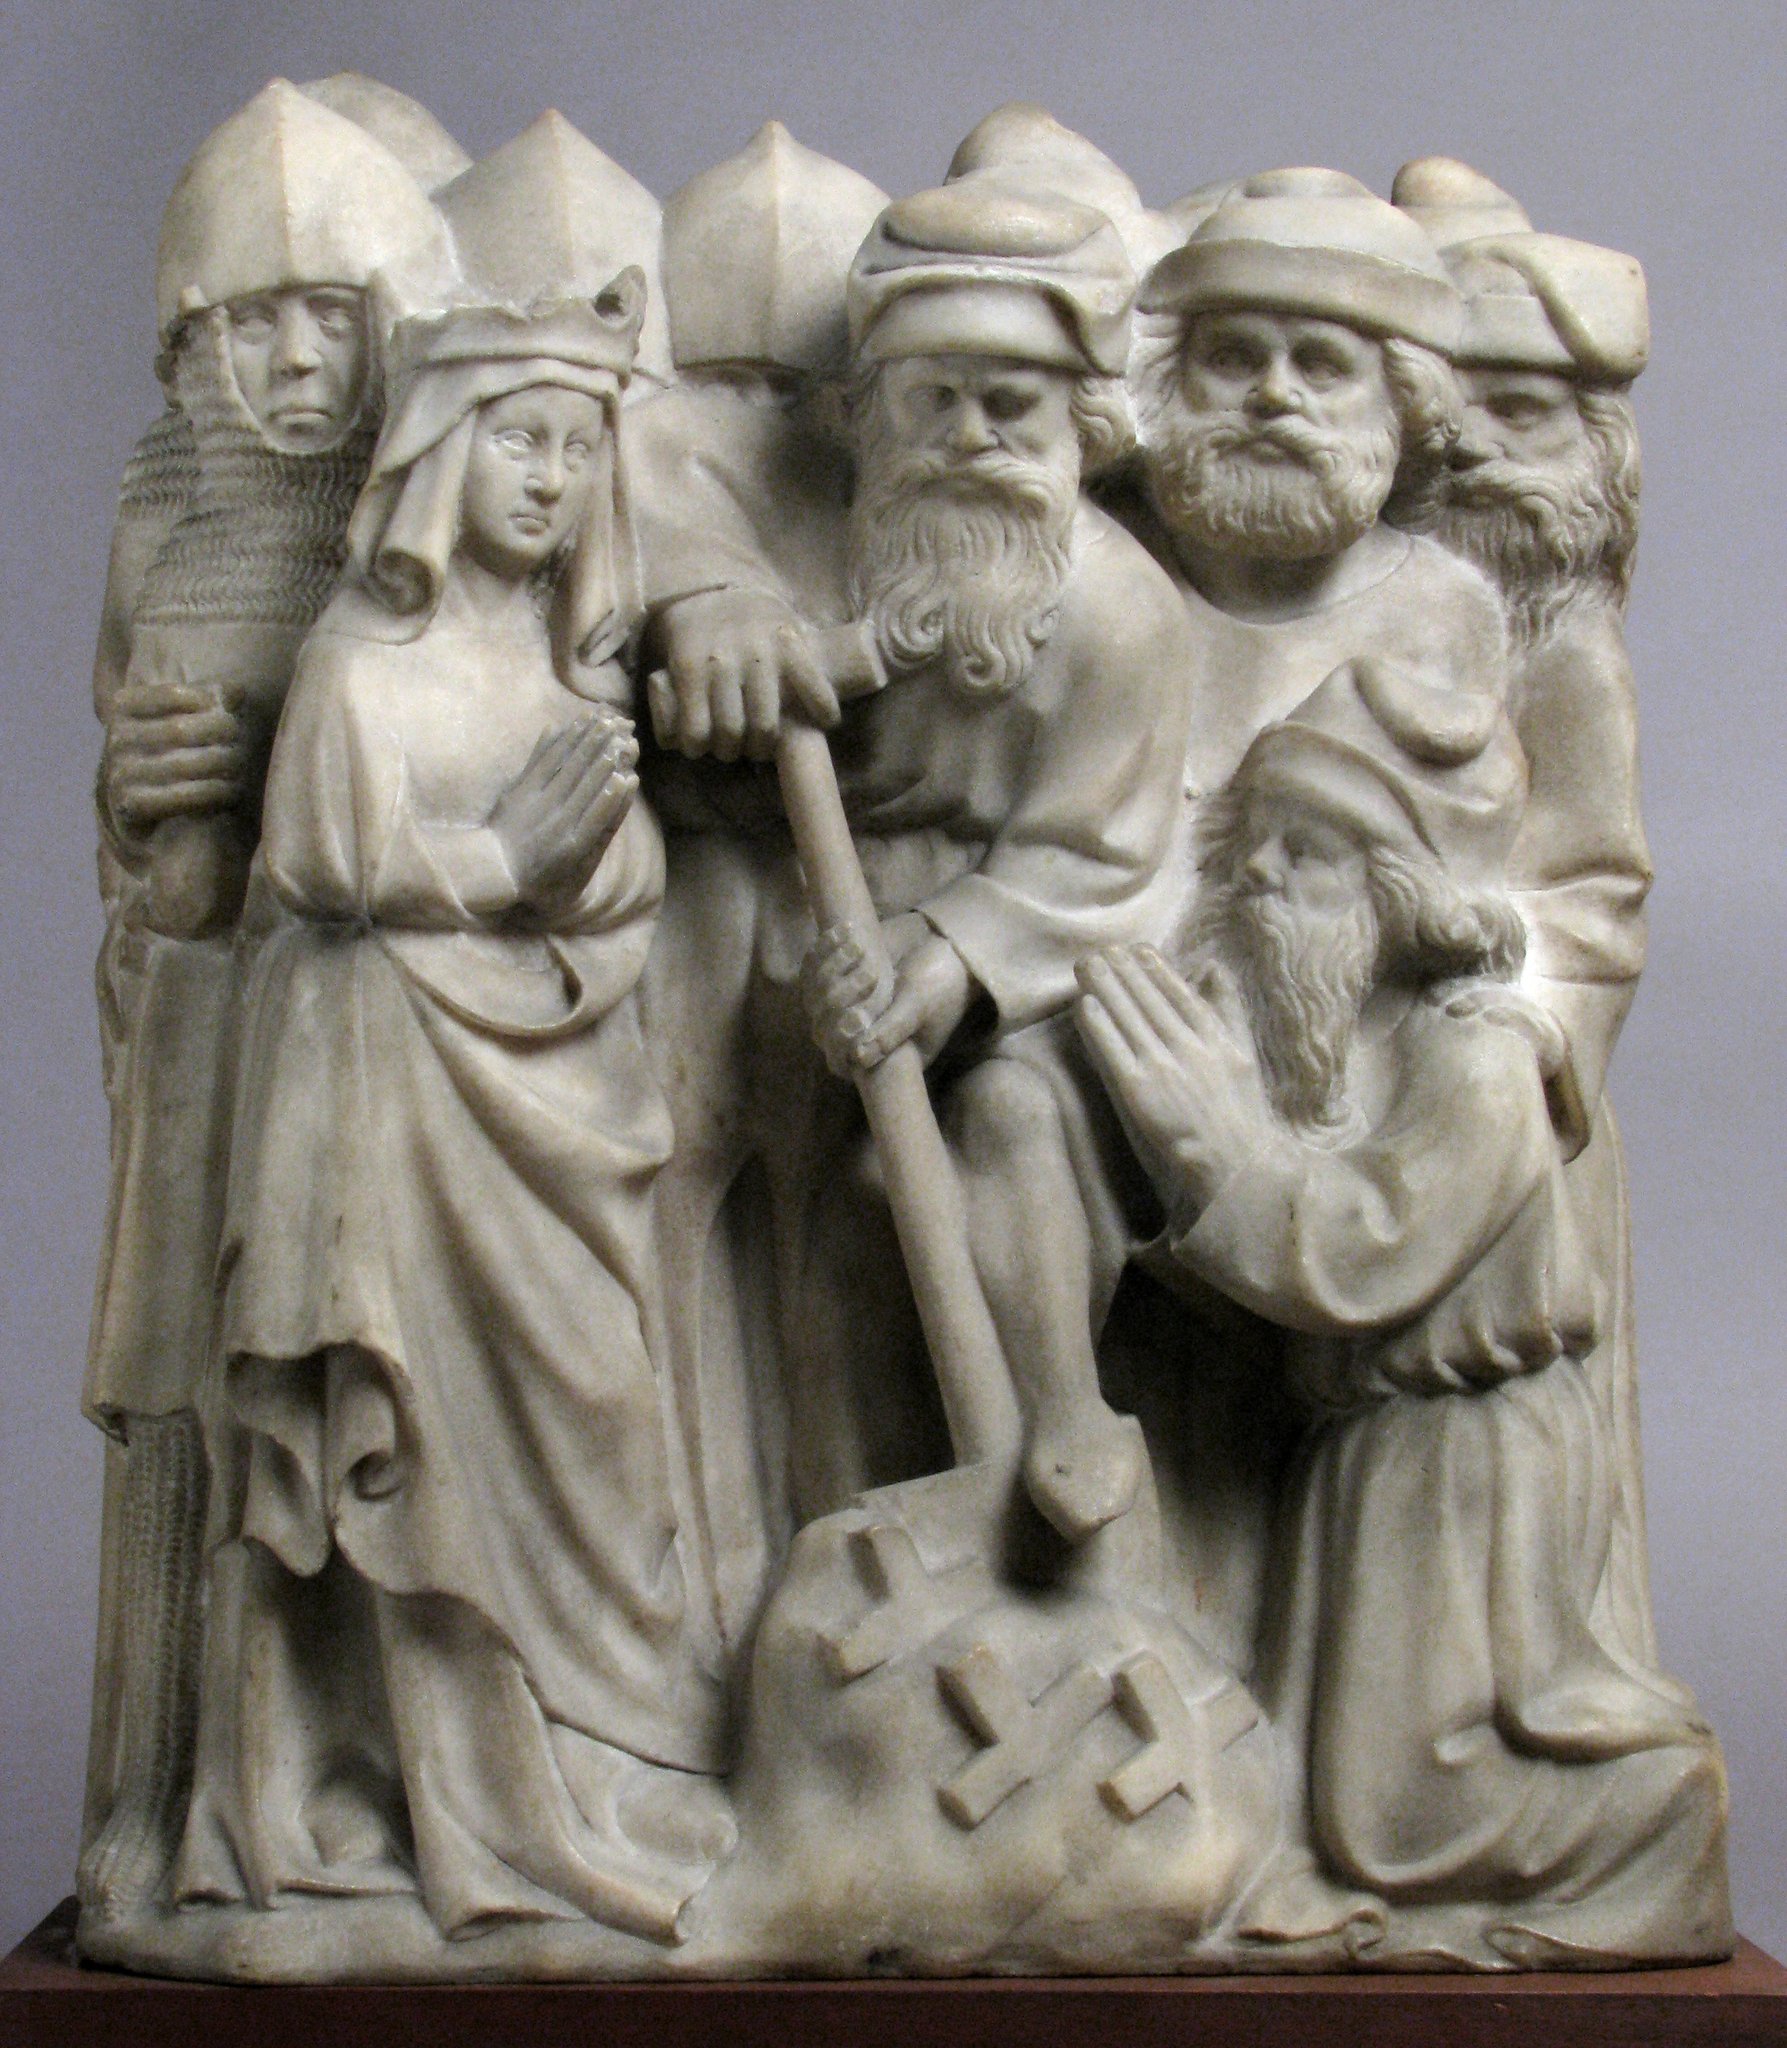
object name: relief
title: Relief with Scene from the Legend of the True Cross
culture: south netherlandish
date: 1400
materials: marble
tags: men,saints